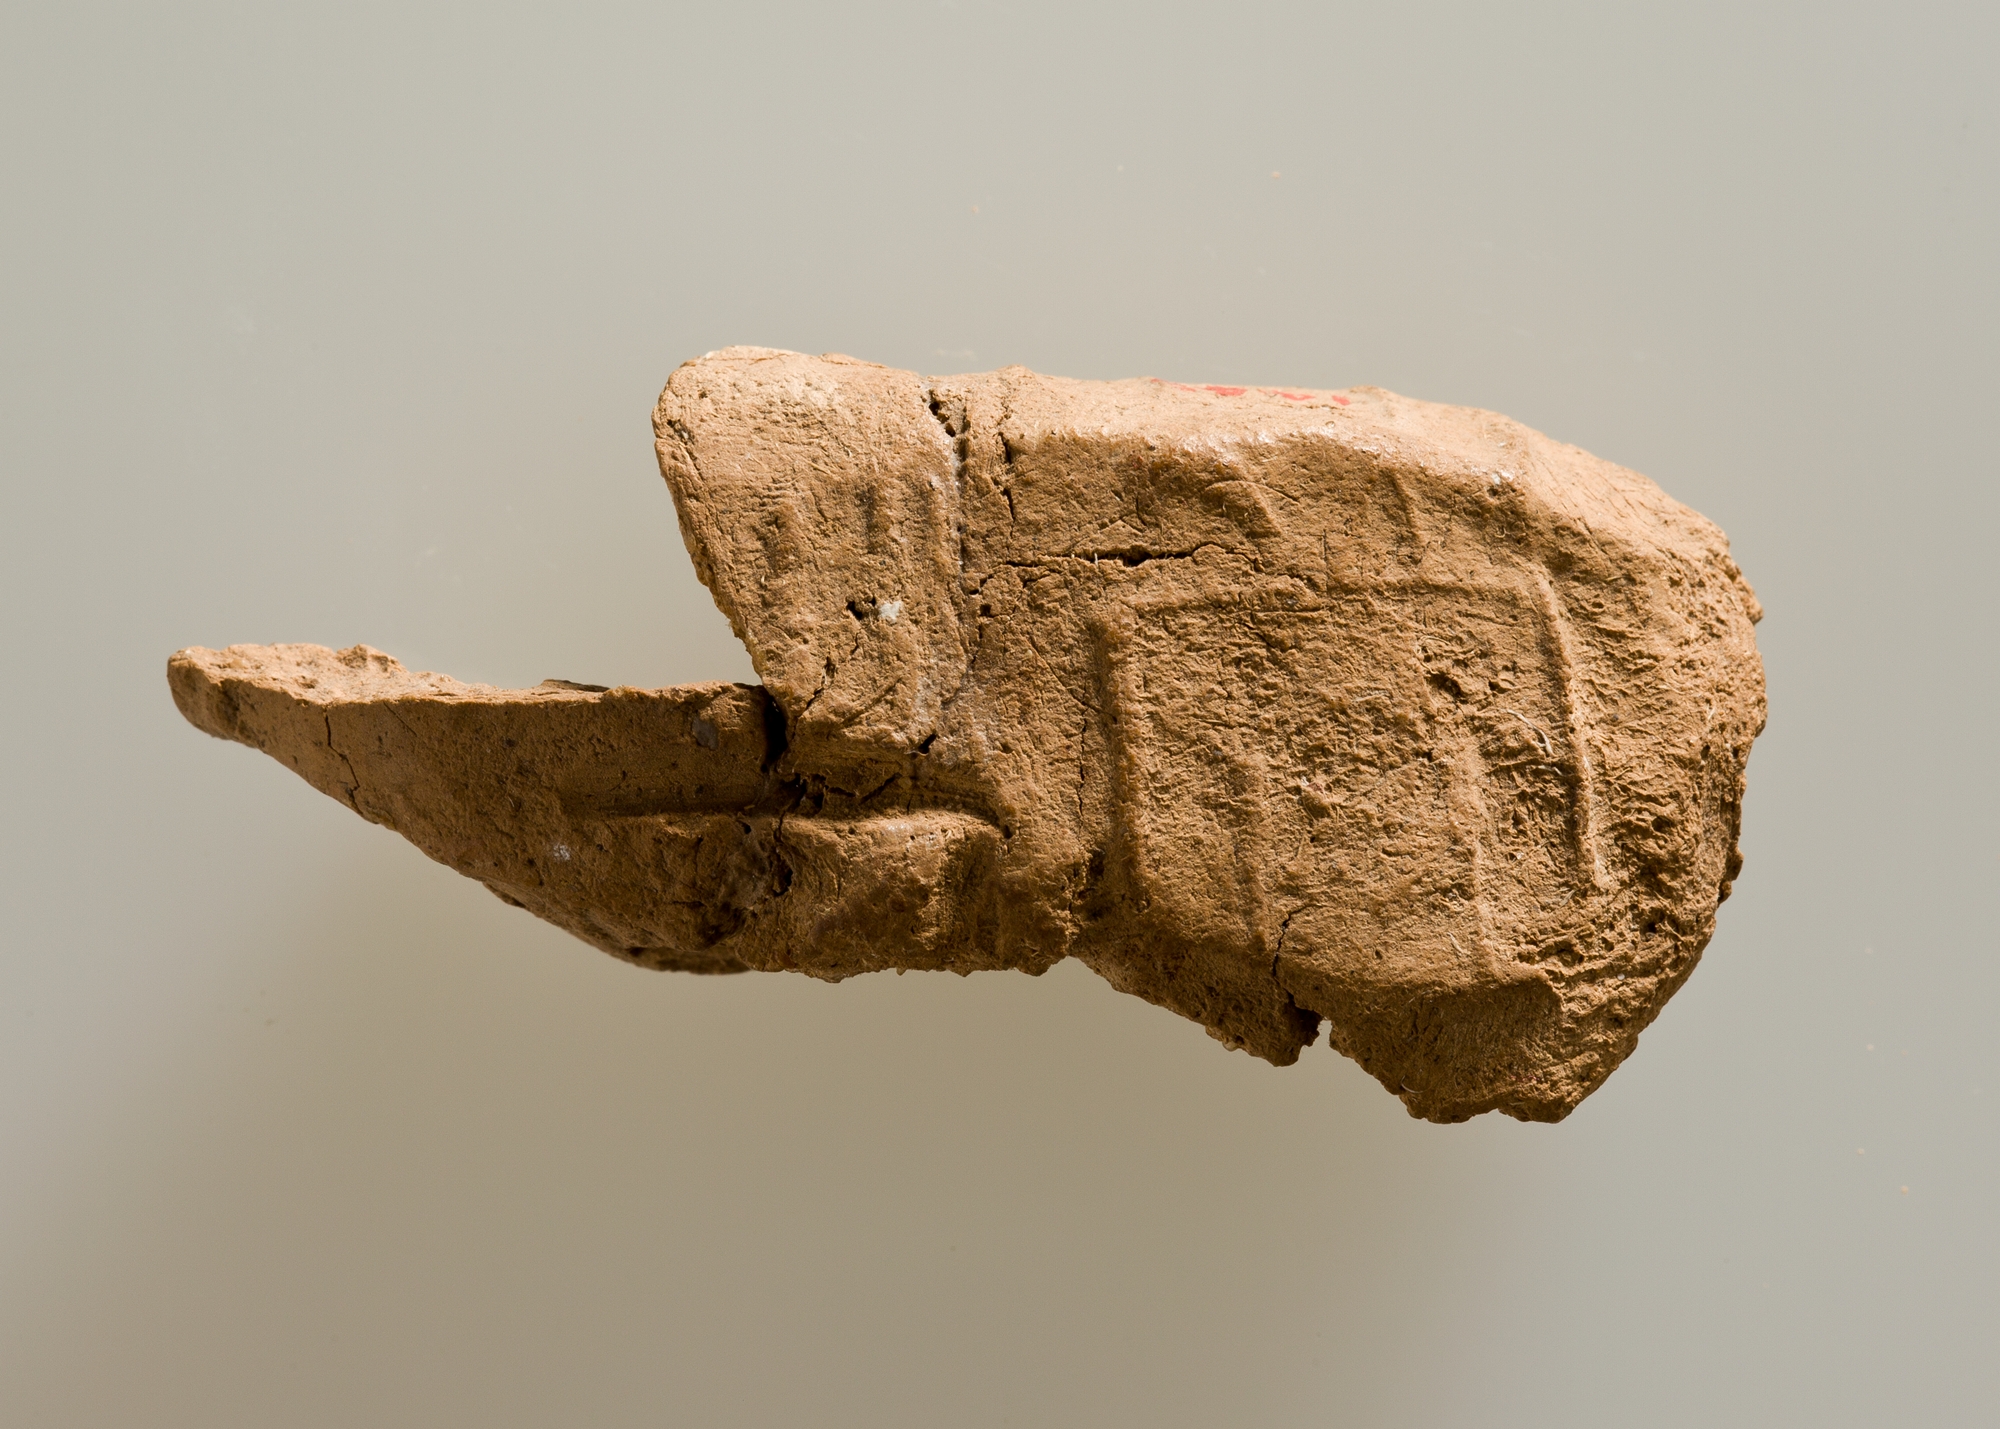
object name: sealing, jar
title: Clay jar sealing impressed faintly with name of Khasekhemwy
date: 2650 BCE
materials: clay